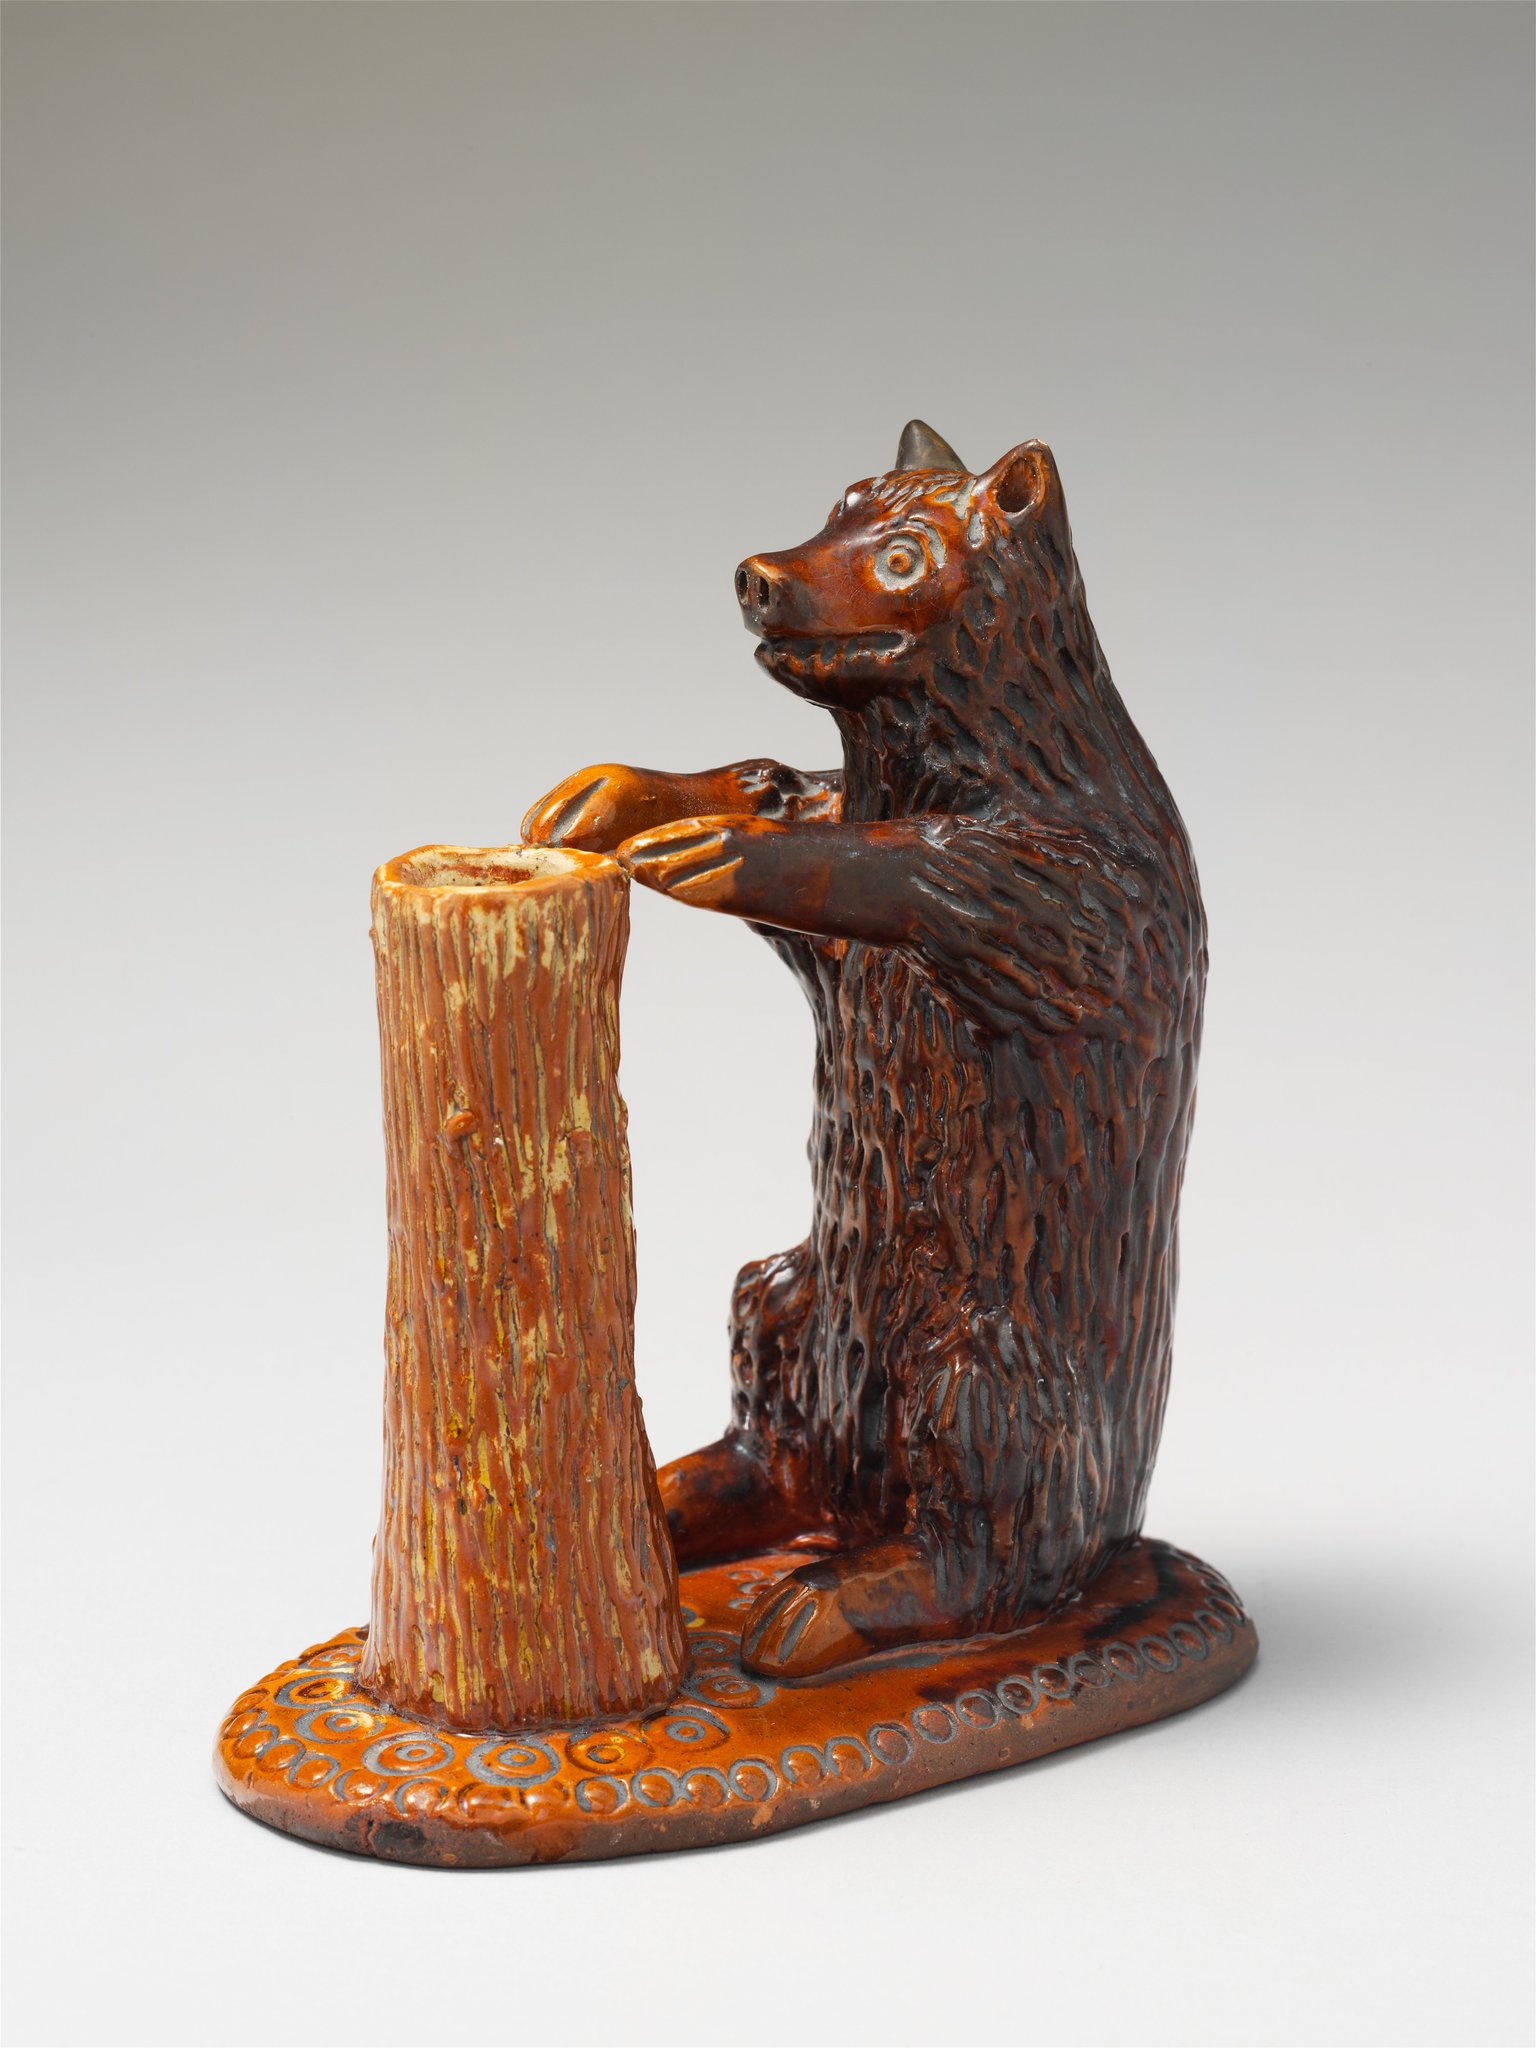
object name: figure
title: Bear figure and spill holder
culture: american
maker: parker pottery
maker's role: maker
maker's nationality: american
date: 1850-1875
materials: earthenware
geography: united states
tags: bears